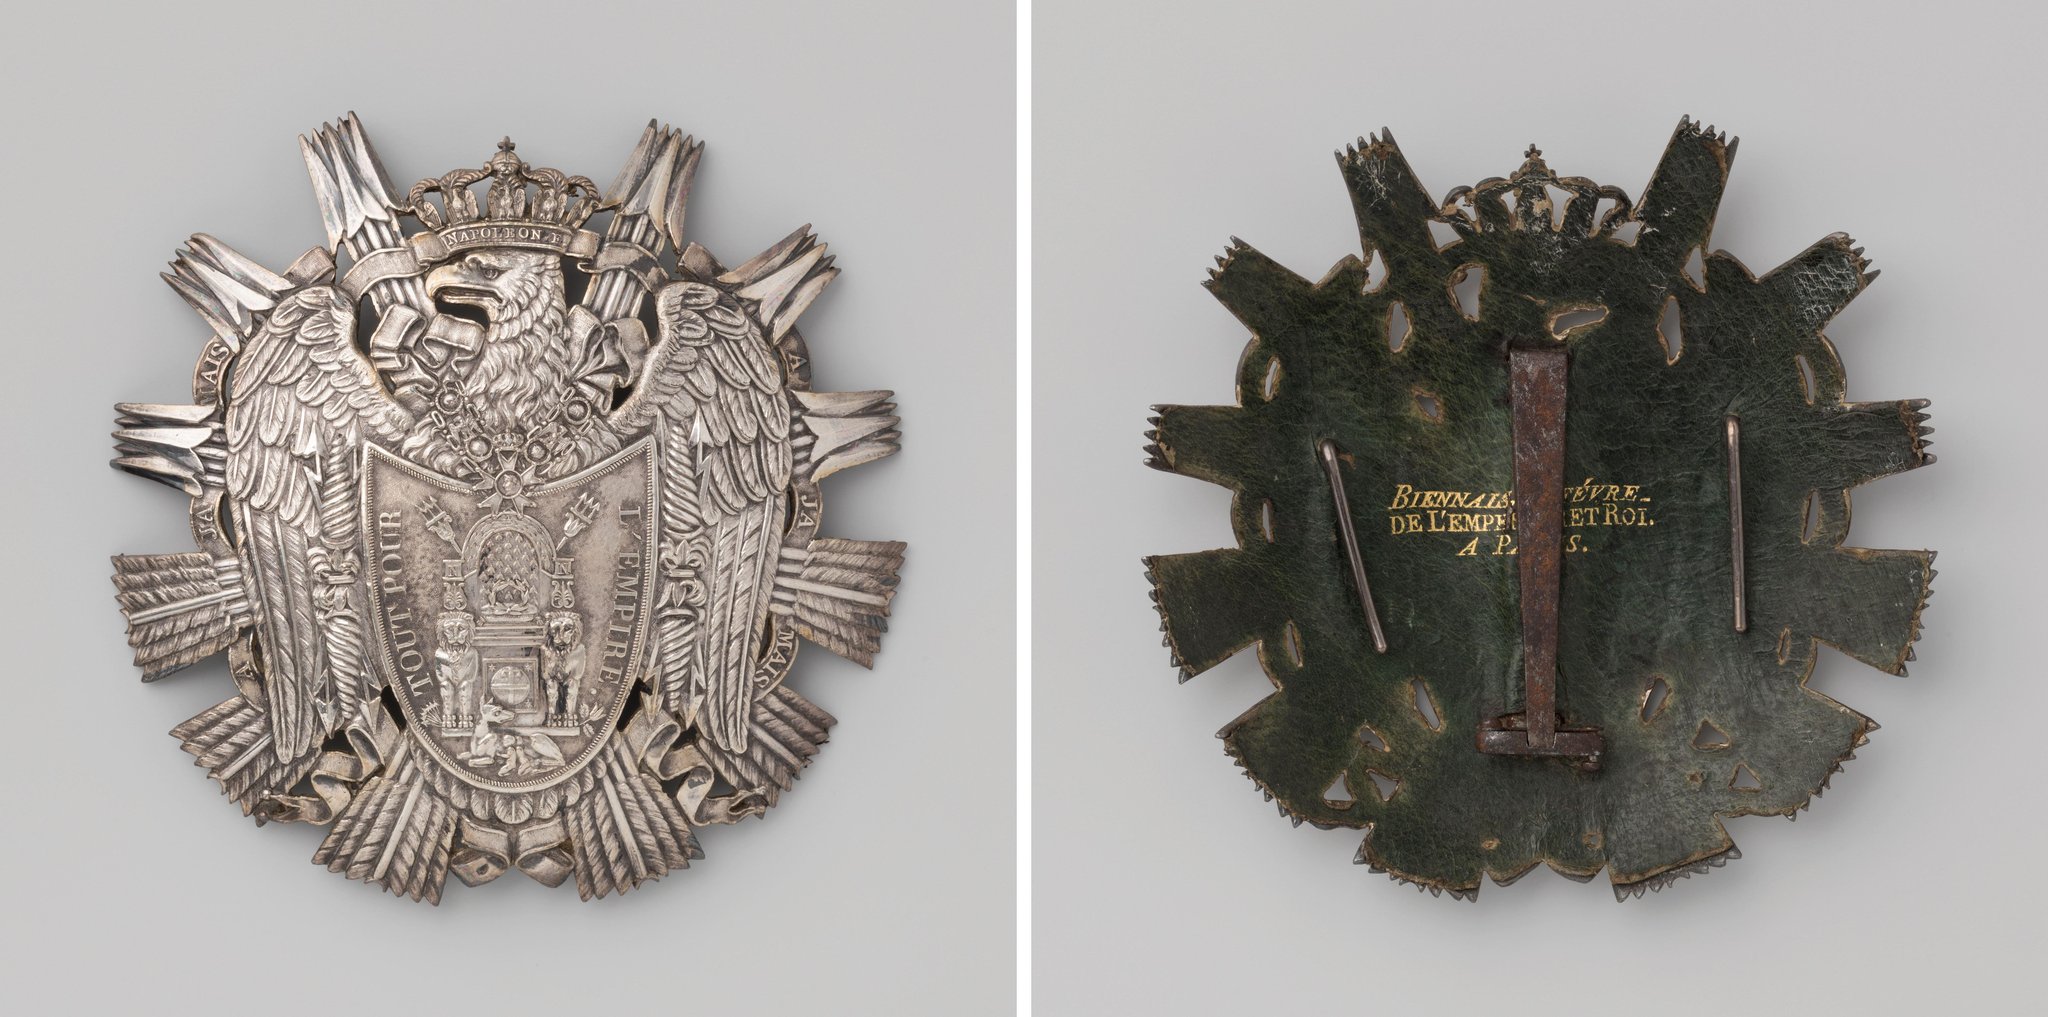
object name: insignia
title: Grootkruis van de Orde van de Reunie van I.J.A. Gogel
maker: martin guillaume biennais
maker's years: 1764-1843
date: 1811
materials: copper, iron, leather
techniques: forging, silvering, striking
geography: paris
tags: napoleon i (emperor of the french)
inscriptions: signature: ‘BIENNAIS (?) ORFEVRE’, inscription: ‘TOUT POUR / L'EMPIRE’, inscription: ‘NAPOLEON F.’, inscription: ‘DE L'EMPEREUR ET ROI’, edge inscription: ‘A JAMAIS’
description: Decorations and medals, 1806-1813. King Louis Napoleon instituted two national orders: the Order of Merit, with the motto 'do well and do not look back', and the Order of the Union, with the motto 'luctor et emergo'. A year later the two orders were merged to form the Royal Order of Holland, renamed the Royal Order of the Union after 1808. Instead of the king's head, the medal showed a bundle of arrows. When the Netherlands was annexed by France in 1810, Emperor Napoleon introduced the Order of Reunion to replace the Order of the Union. These decorations were originally awarded to I.J.A. Gogel, who served for many years as minister of finance.